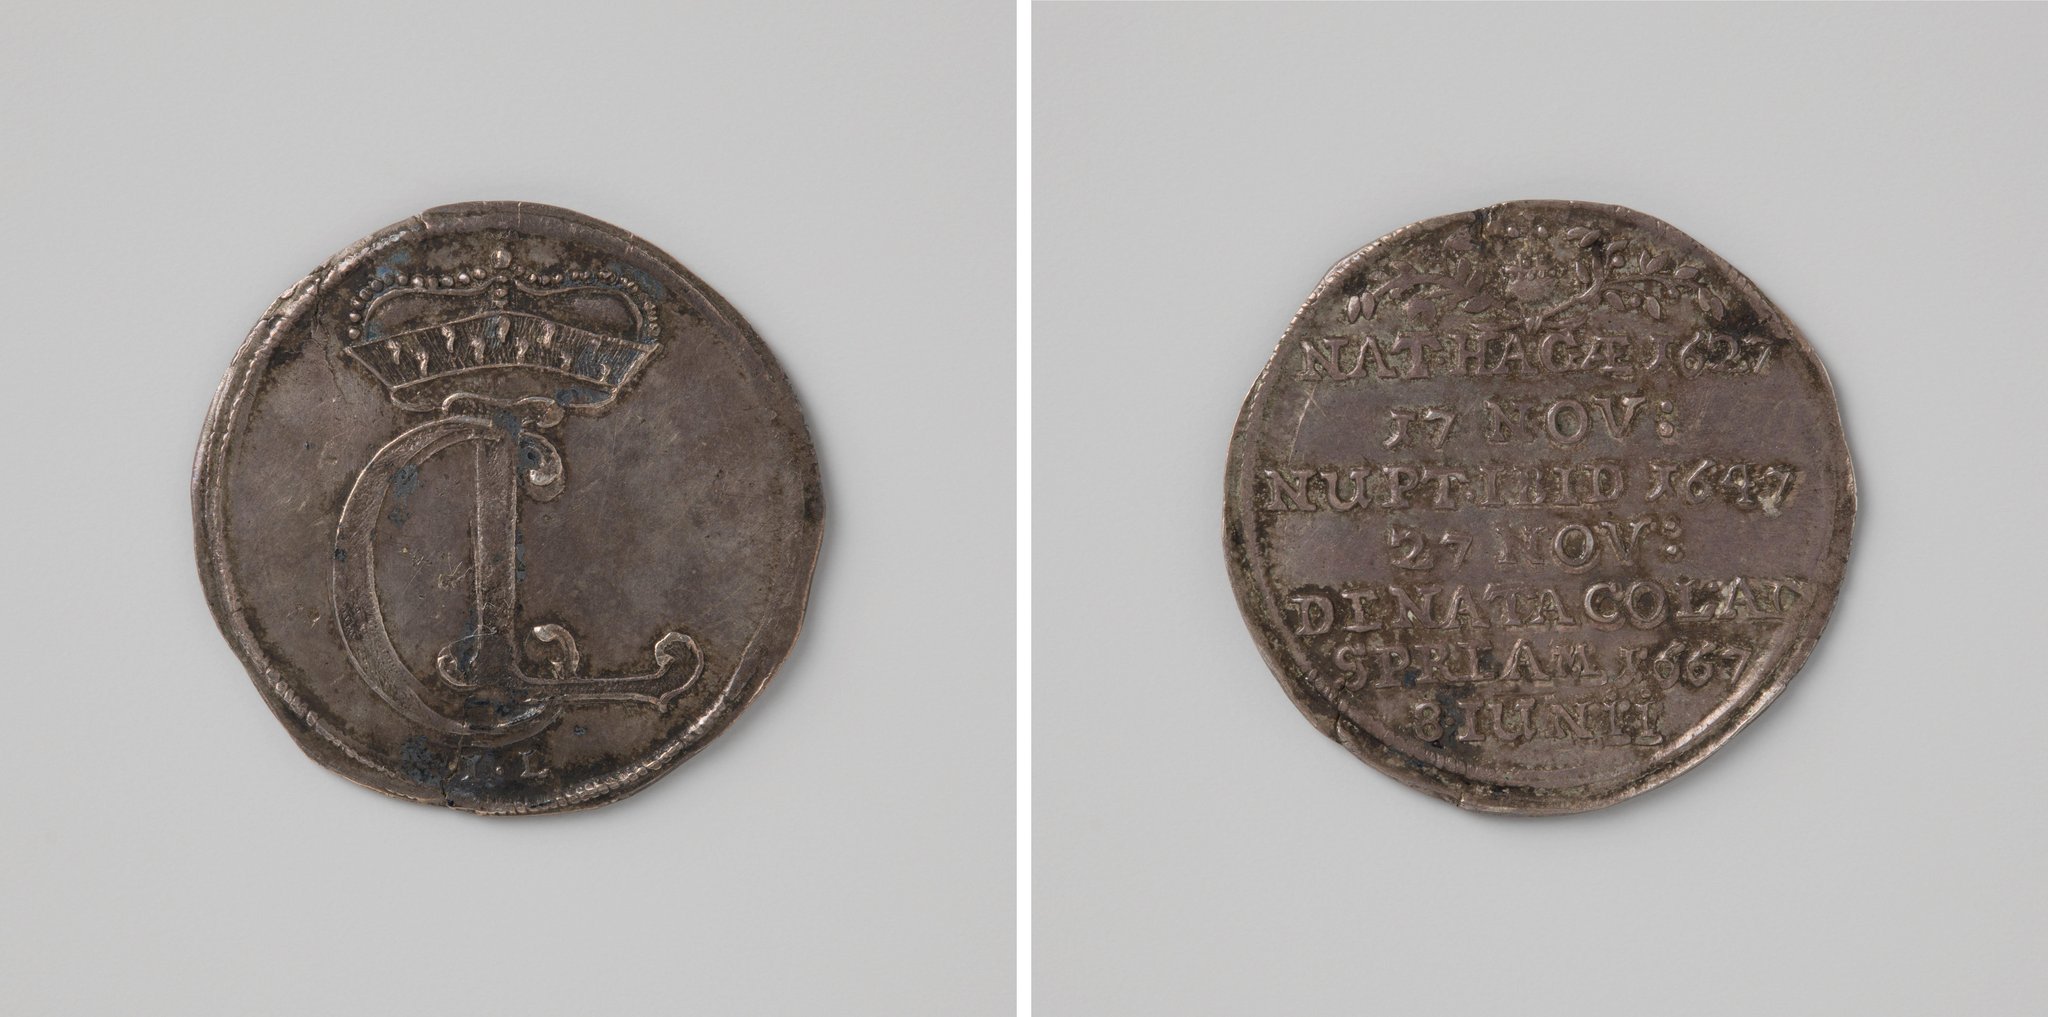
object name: overlijdenspenning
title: Dood van prinses Louise Henriette van Oranje, gemalin van Frederik Willem, keurvorst van Brandenburg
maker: johann liebmann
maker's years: 1646-1682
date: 1667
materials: silver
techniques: striking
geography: berlin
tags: the hague, berlin, louise henriëtte (prinses van oranje)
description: Zilveren penning. Voorzijde: gekroond monogram CL. Keerzijde: opschrift